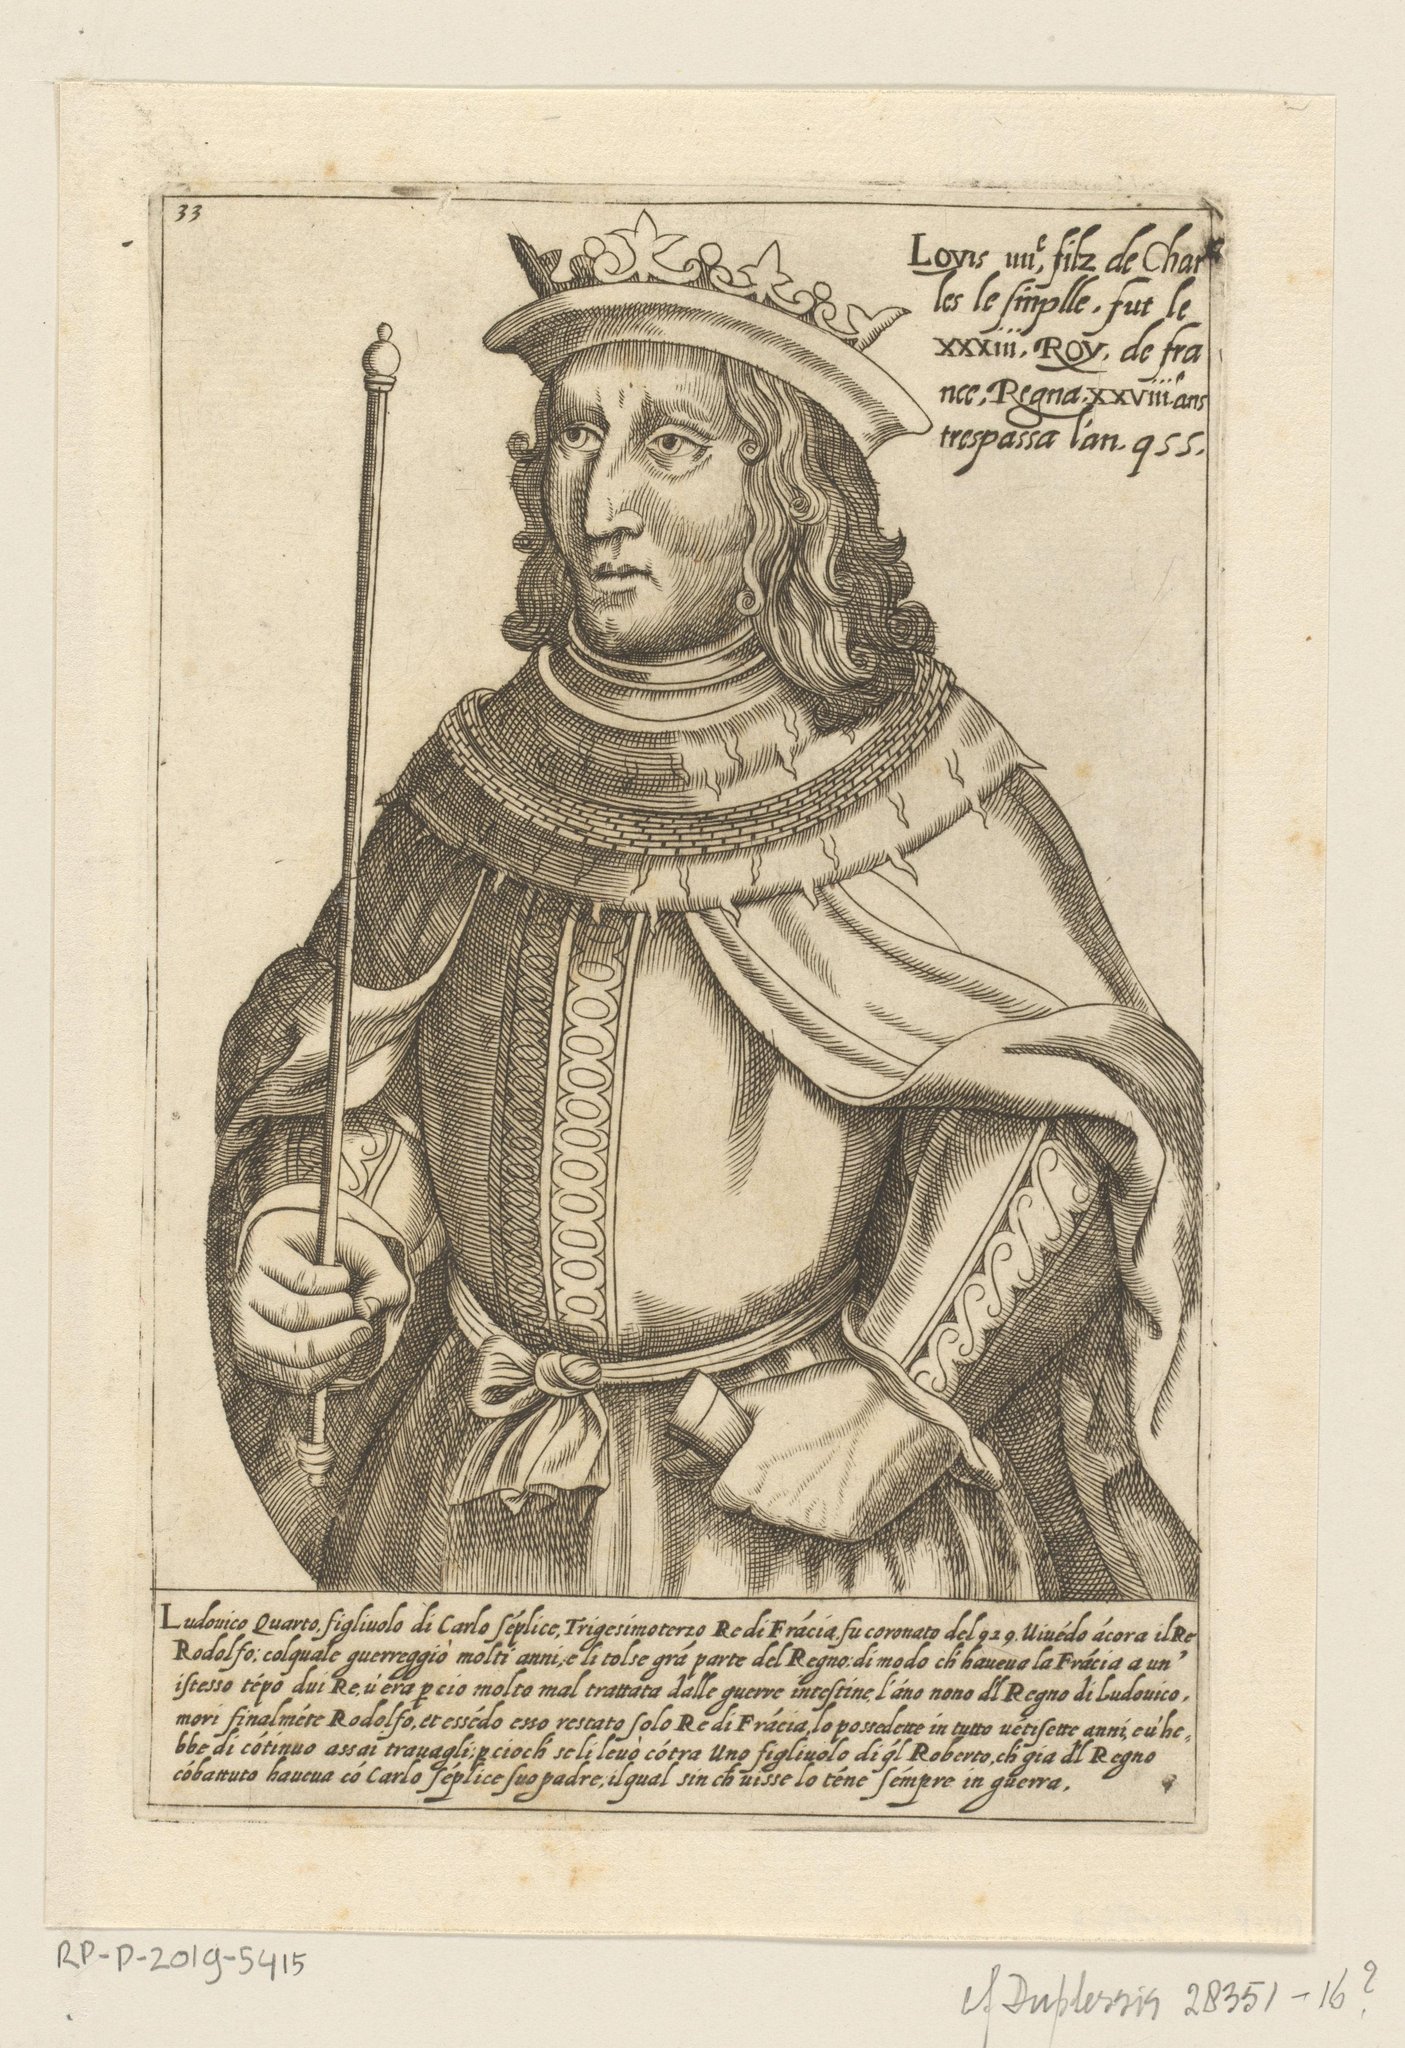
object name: book illustration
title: Portret van Lodewijk IV, koning van West-Francië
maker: Anonymous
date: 1588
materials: paper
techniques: engraving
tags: london, crown (symbol of sovereignty), sceptre, staff (symbol of sovereignty), historical persons, king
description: Prent voor het eerst gebruikt in: Cronica Breve de i fatti illustri de're di Francia, con le loro effigie dal naturale cominciando da Faramondo (...). Venetië: Bernardo Giunti, 1588. Prent in ieder geval ook gebruikt in de editie van 1590 en mogelijk ook in een Franse uitgave van 1597.